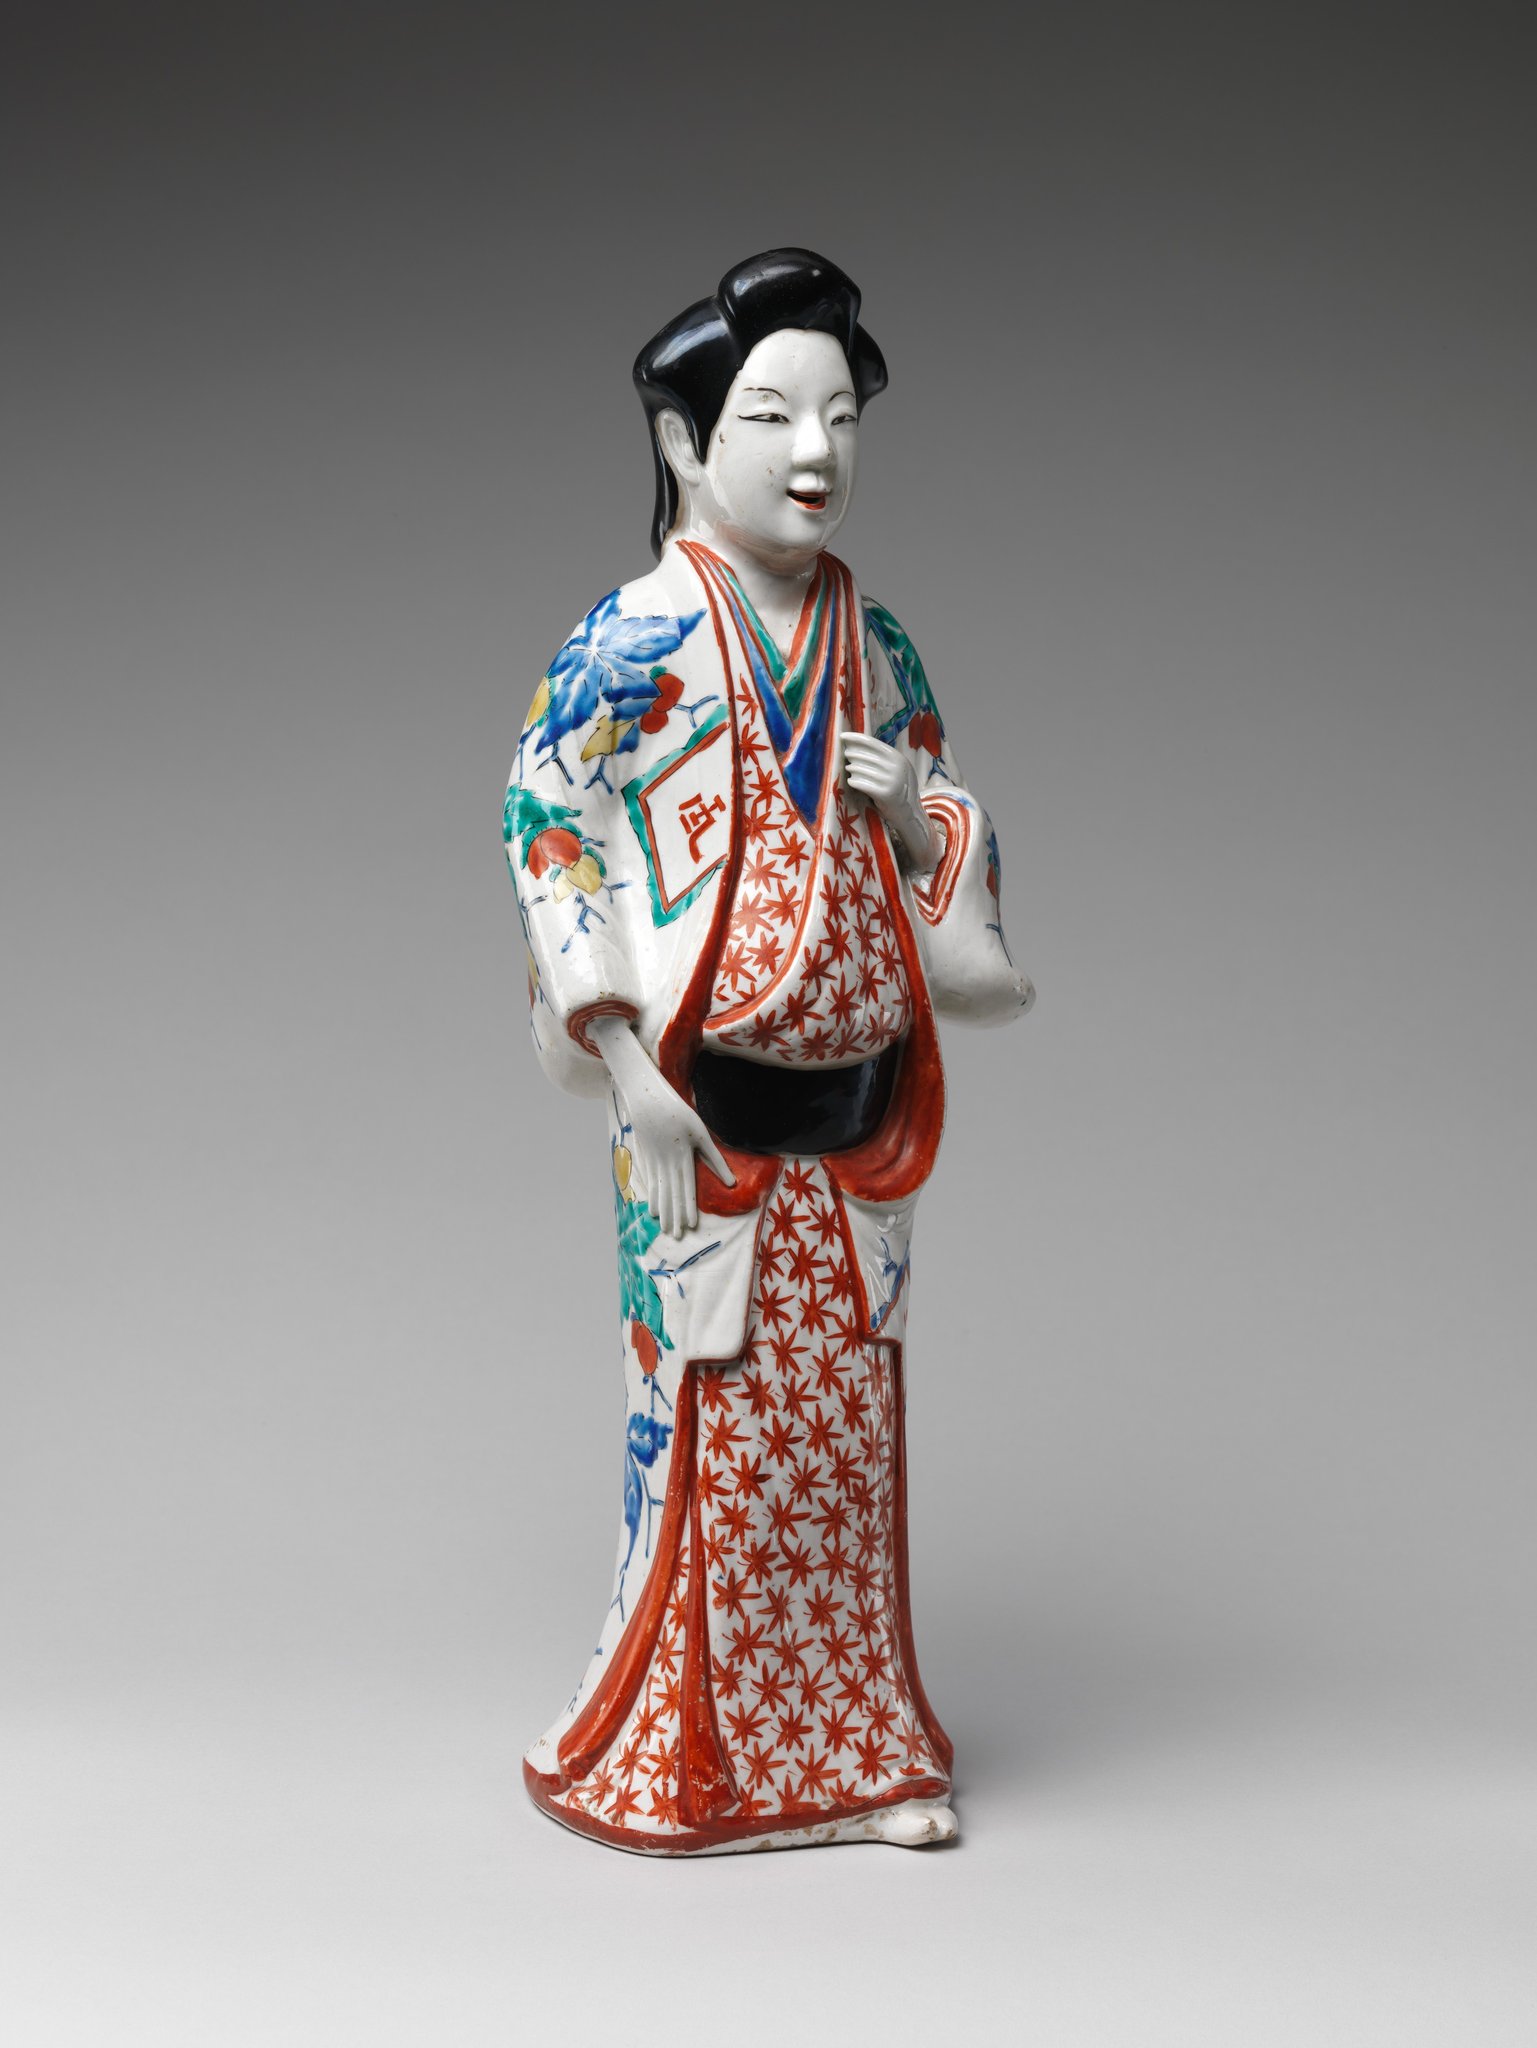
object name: figure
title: Figure of a Standing Beauty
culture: japanese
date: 1670-1690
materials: enamel, porcelain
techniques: overglaze, polychrome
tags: women